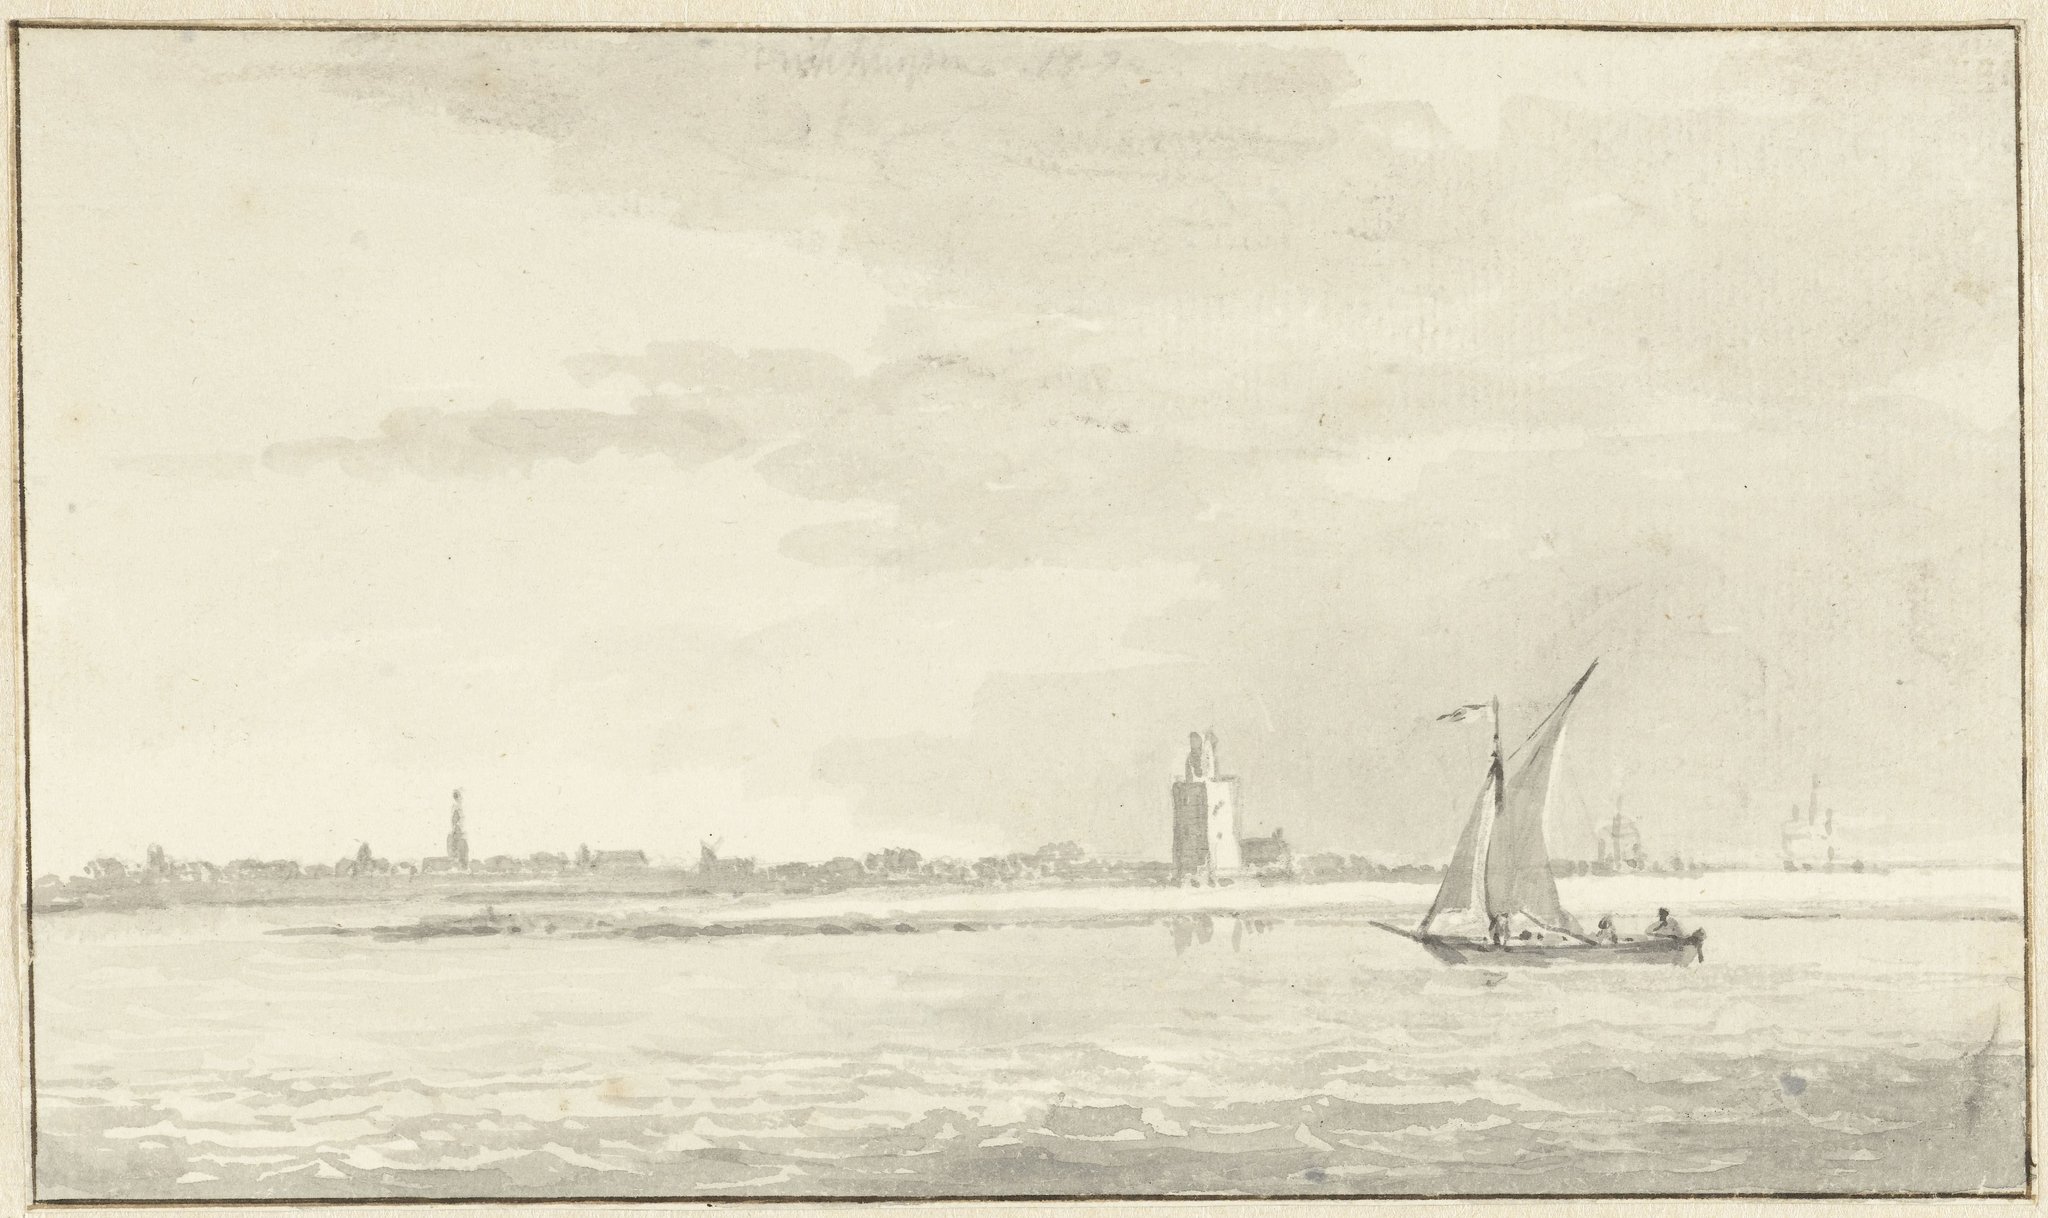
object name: drawing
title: Gezicht op Enkhuizen van zee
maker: aert schouman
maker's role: draughtsman, painter, print maker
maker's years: 1710-1792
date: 1772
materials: ink, paper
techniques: brush, pen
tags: prospect of city, town panorama, silhouette of city, enkhuizen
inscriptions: inscription: ‘Enkhuysen en Steene Baken 1772 . A: S. chouman’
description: Gezicht op Enkhuizen van zee; met een zeilschip en de stenen vuurbaak.